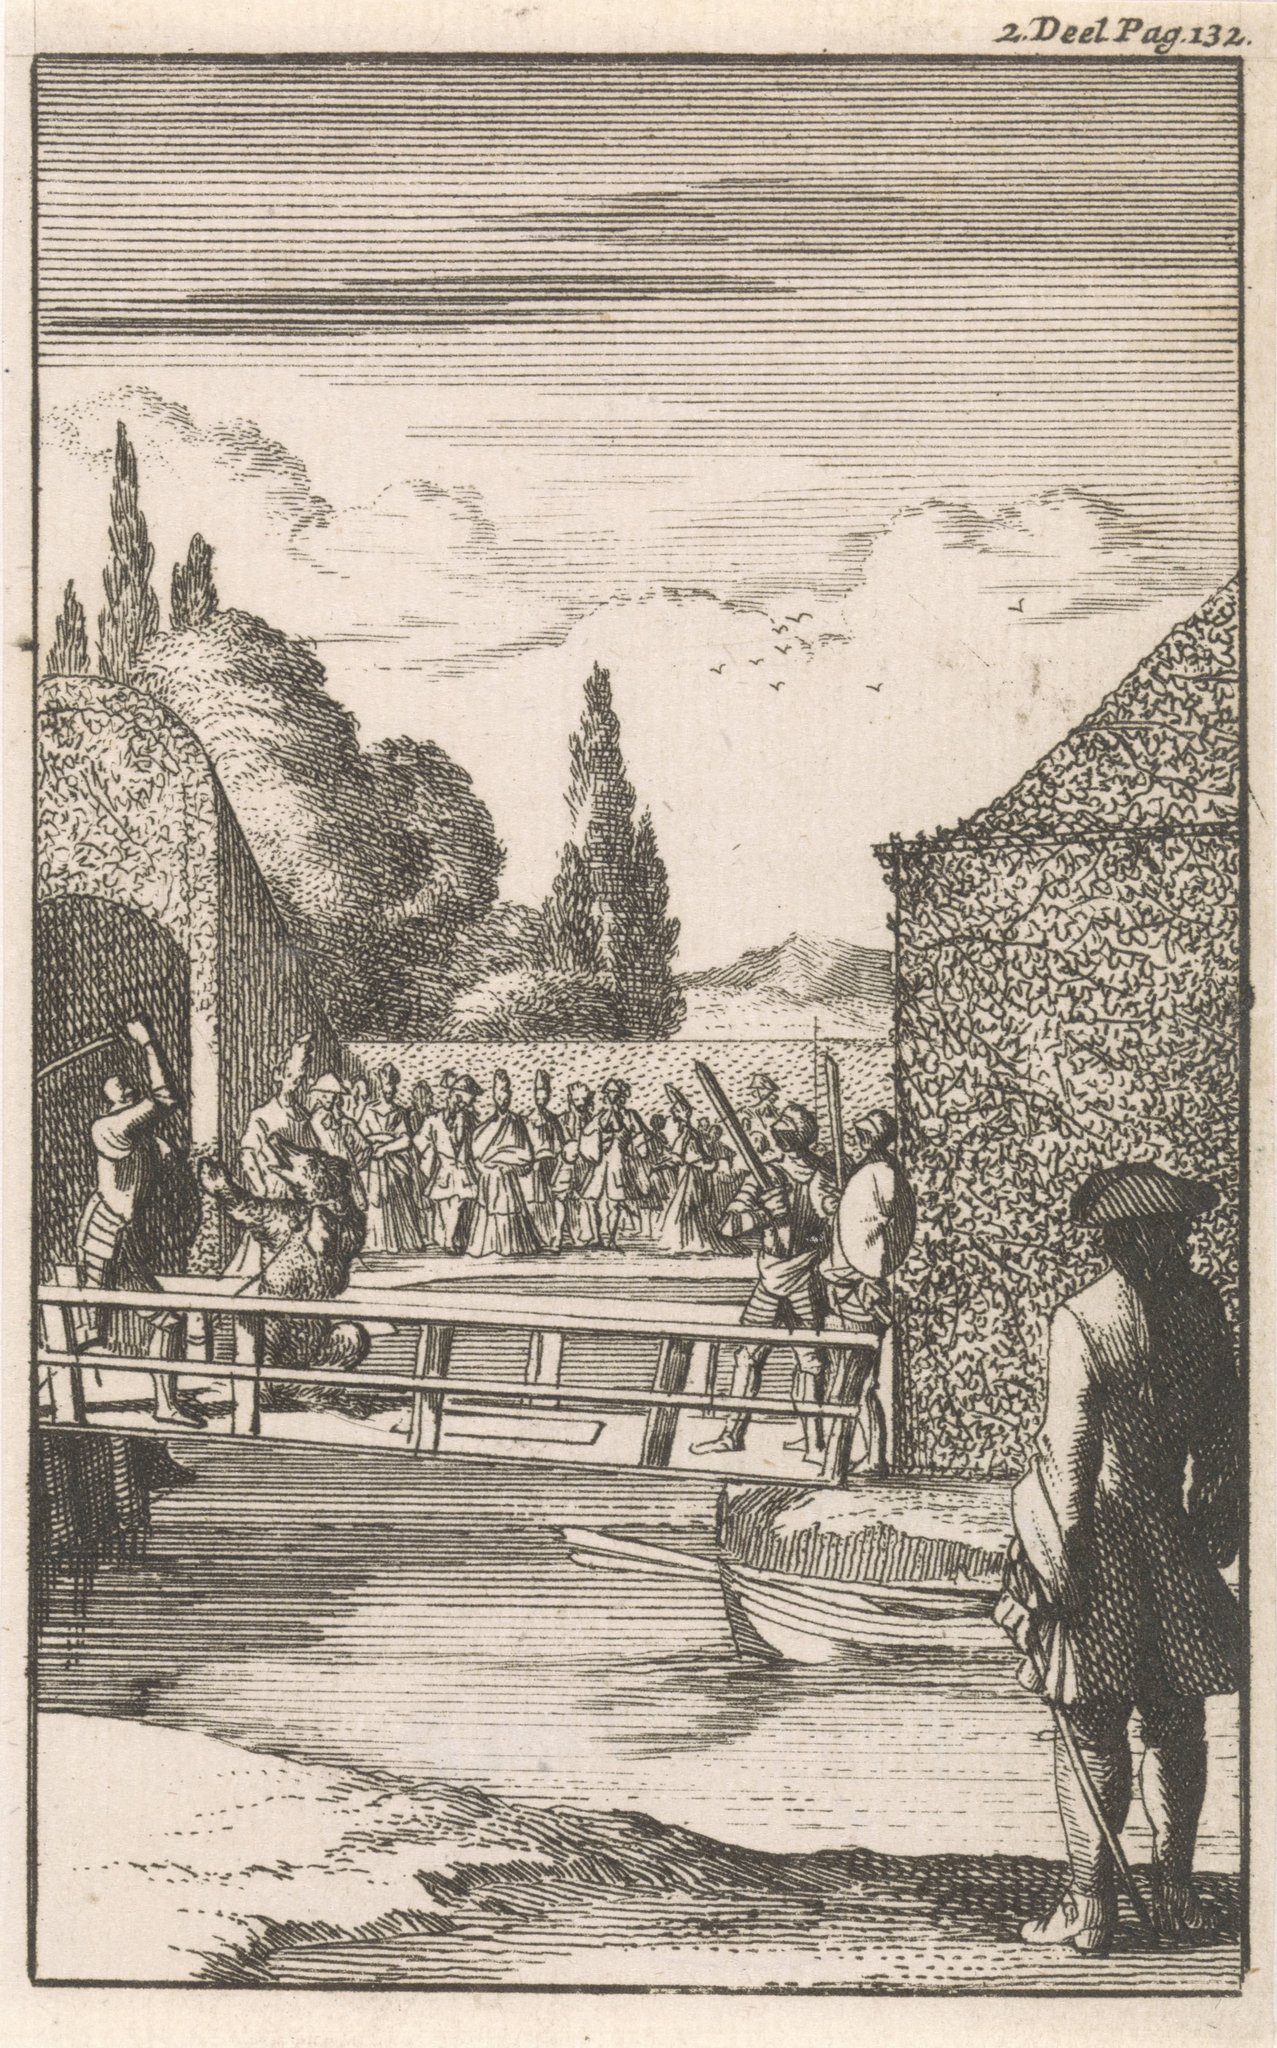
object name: print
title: Gevecht van Don Clarazel met een beer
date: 1697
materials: paper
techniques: etching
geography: amsterdam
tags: fight between man and animal, beasts of prey, predatory animals: bear, knight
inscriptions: collector's mark: Lugt 2228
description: Illustratie uit: Verdier, Gilbert Saulnier du (vert. Heinsius, Nicolaas junior). Don Clarazel de Gontarnos, ofte den buiten-spoorigen dolenden ridder, 2 delen. Amsterdam: Johannes Broersz en Nathanael Holbeex, 1697, dl. 2.